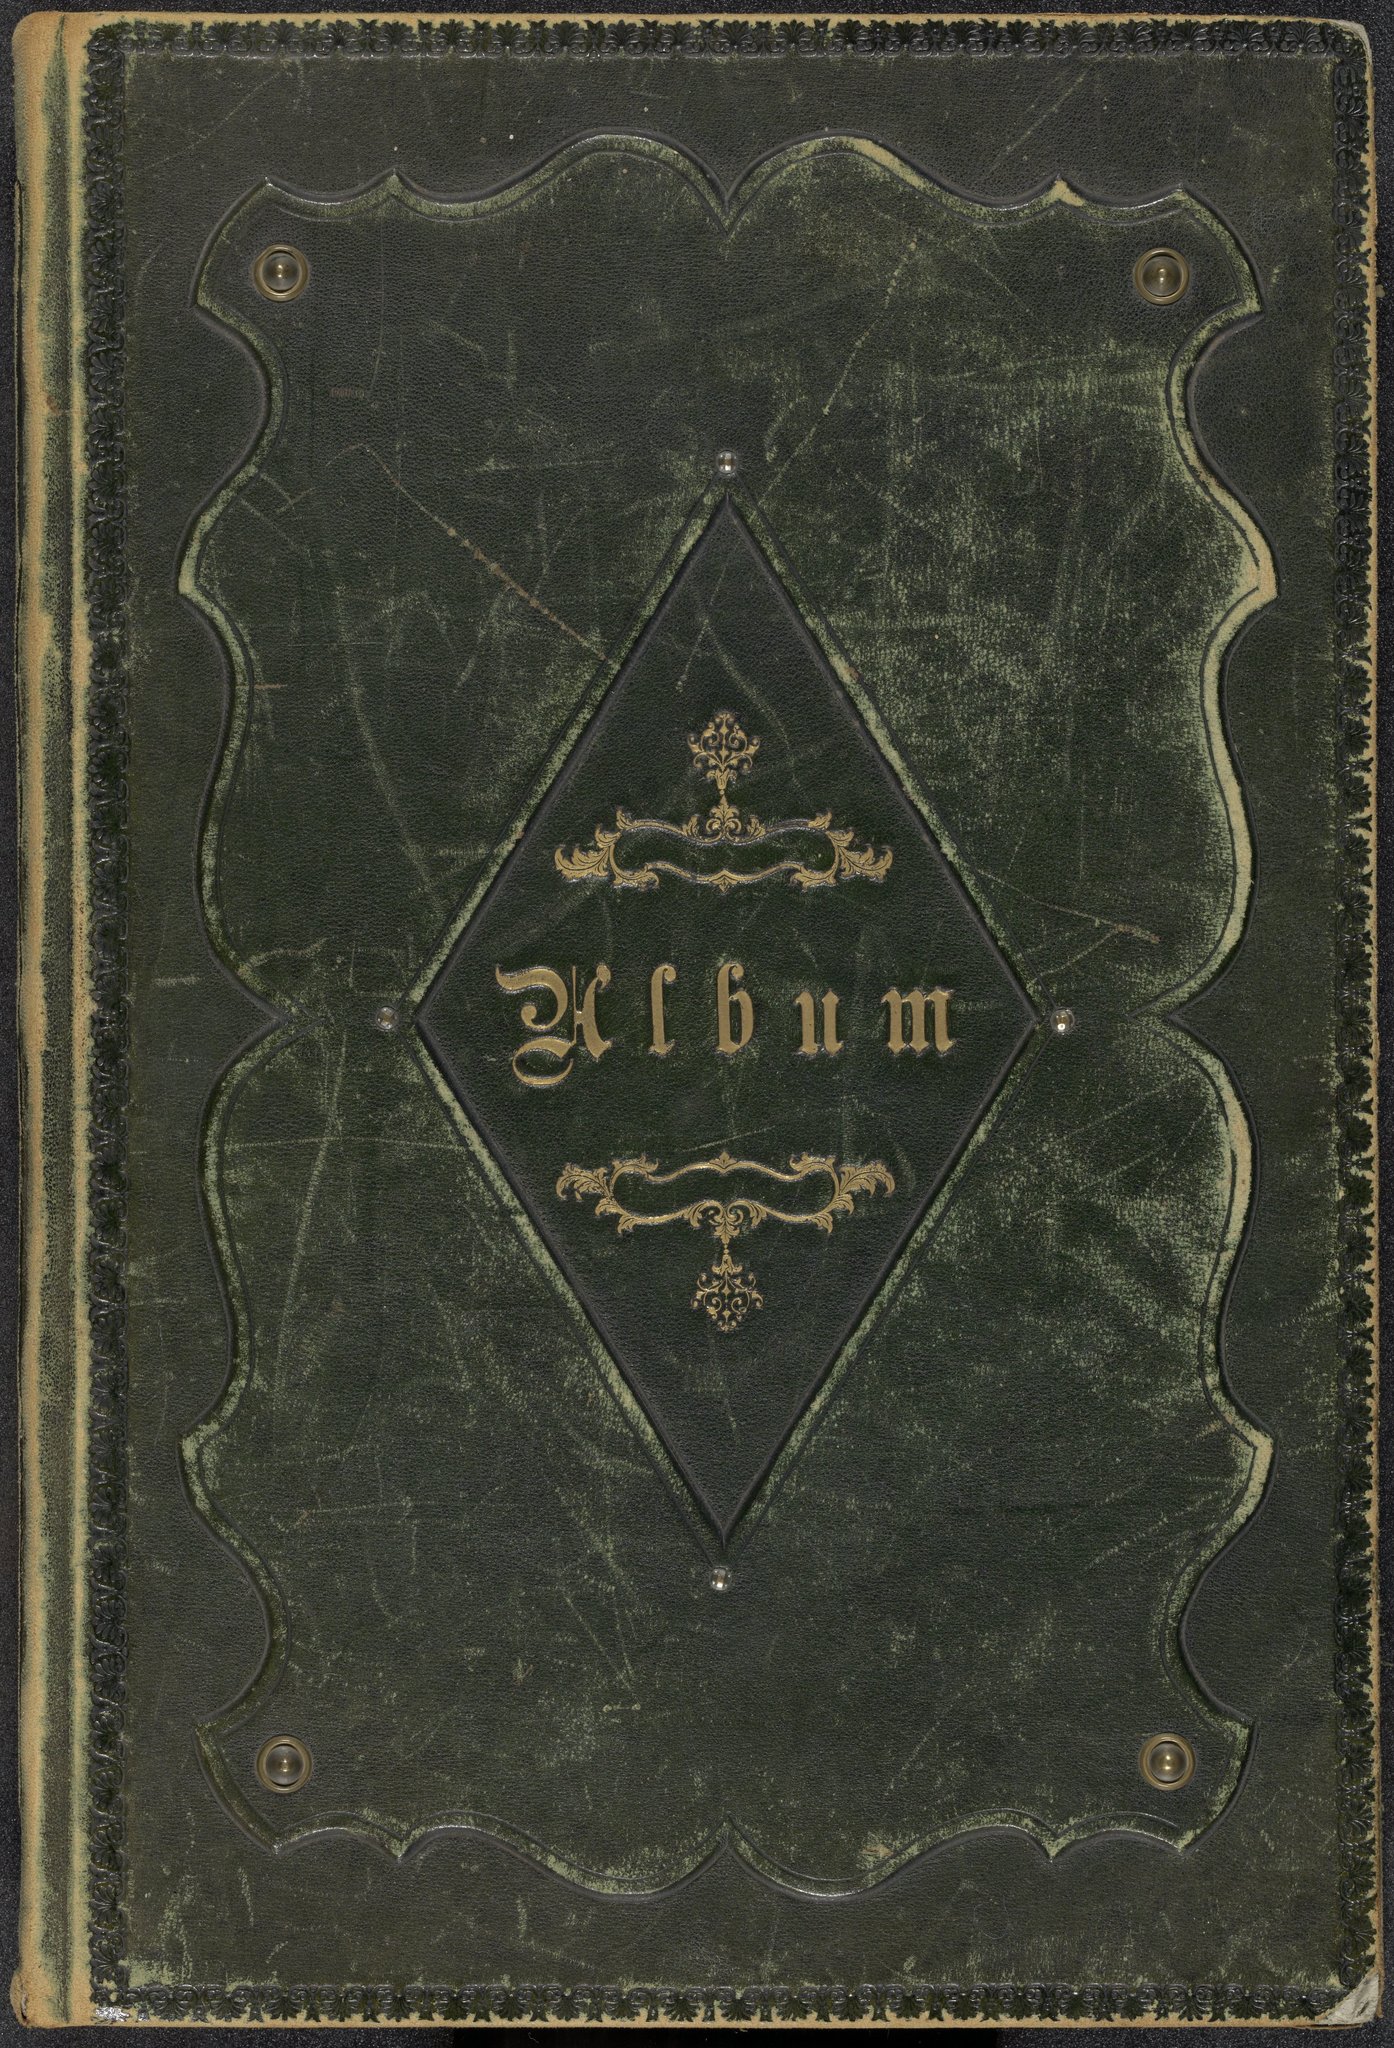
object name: photograph album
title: Fotoalbum van Robert Daniel Crommelin (1841-1907)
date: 1863-1898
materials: cardboard, leather, metal, paper, photographic support, silk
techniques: albumen print, photograph, lithograph, weave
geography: amsterdam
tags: claude august crommelin (1840-1874), amsterdam, arnhem, family life, travelling; tourism, netherlands, italy, germany, dutch east indies, the, france, japan, switzerland, belgium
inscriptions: inscription: ‘F.L. van der Bom Boekbinder Amsterdam’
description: Fotoalbum in groene imitatieleren band, versierd met geometrische en plantmotieven in reliëf en gouddruk. Op het voor- en achterplat zijn acht metalen knopjes aangebracht. De schutbladen zijn van changeant papier. De band bevat 50 albumbladen goud op snee met 270 foto's uit de jaren 1863-1898. Een deel daarvan is vermoedelijk gemaakt door Claude August Crommelin (1840-1874), bekend verzamelaar van kunst en liefhebber van fotografie die in 1864 een fotoatelier van gietijzer en glas in de tuin achter Herengracht 132 liet bouwen. Het album, dat toebehoorde aan Robert Daniel Crommelin (1841-1907), bevat naast familiefoto's ook opnames van België, Schotland, Duitsland, Zwitserland, Frankrijk, Italië, Nederlands-Indië, Japan (Deshima), Hong Kong en Nagasaki. Ook het Bombardement van Shimonoseki (1863-1864) komt aan bod en er is een bijzondere foto van Roma's in Amsterdam uit 1879.